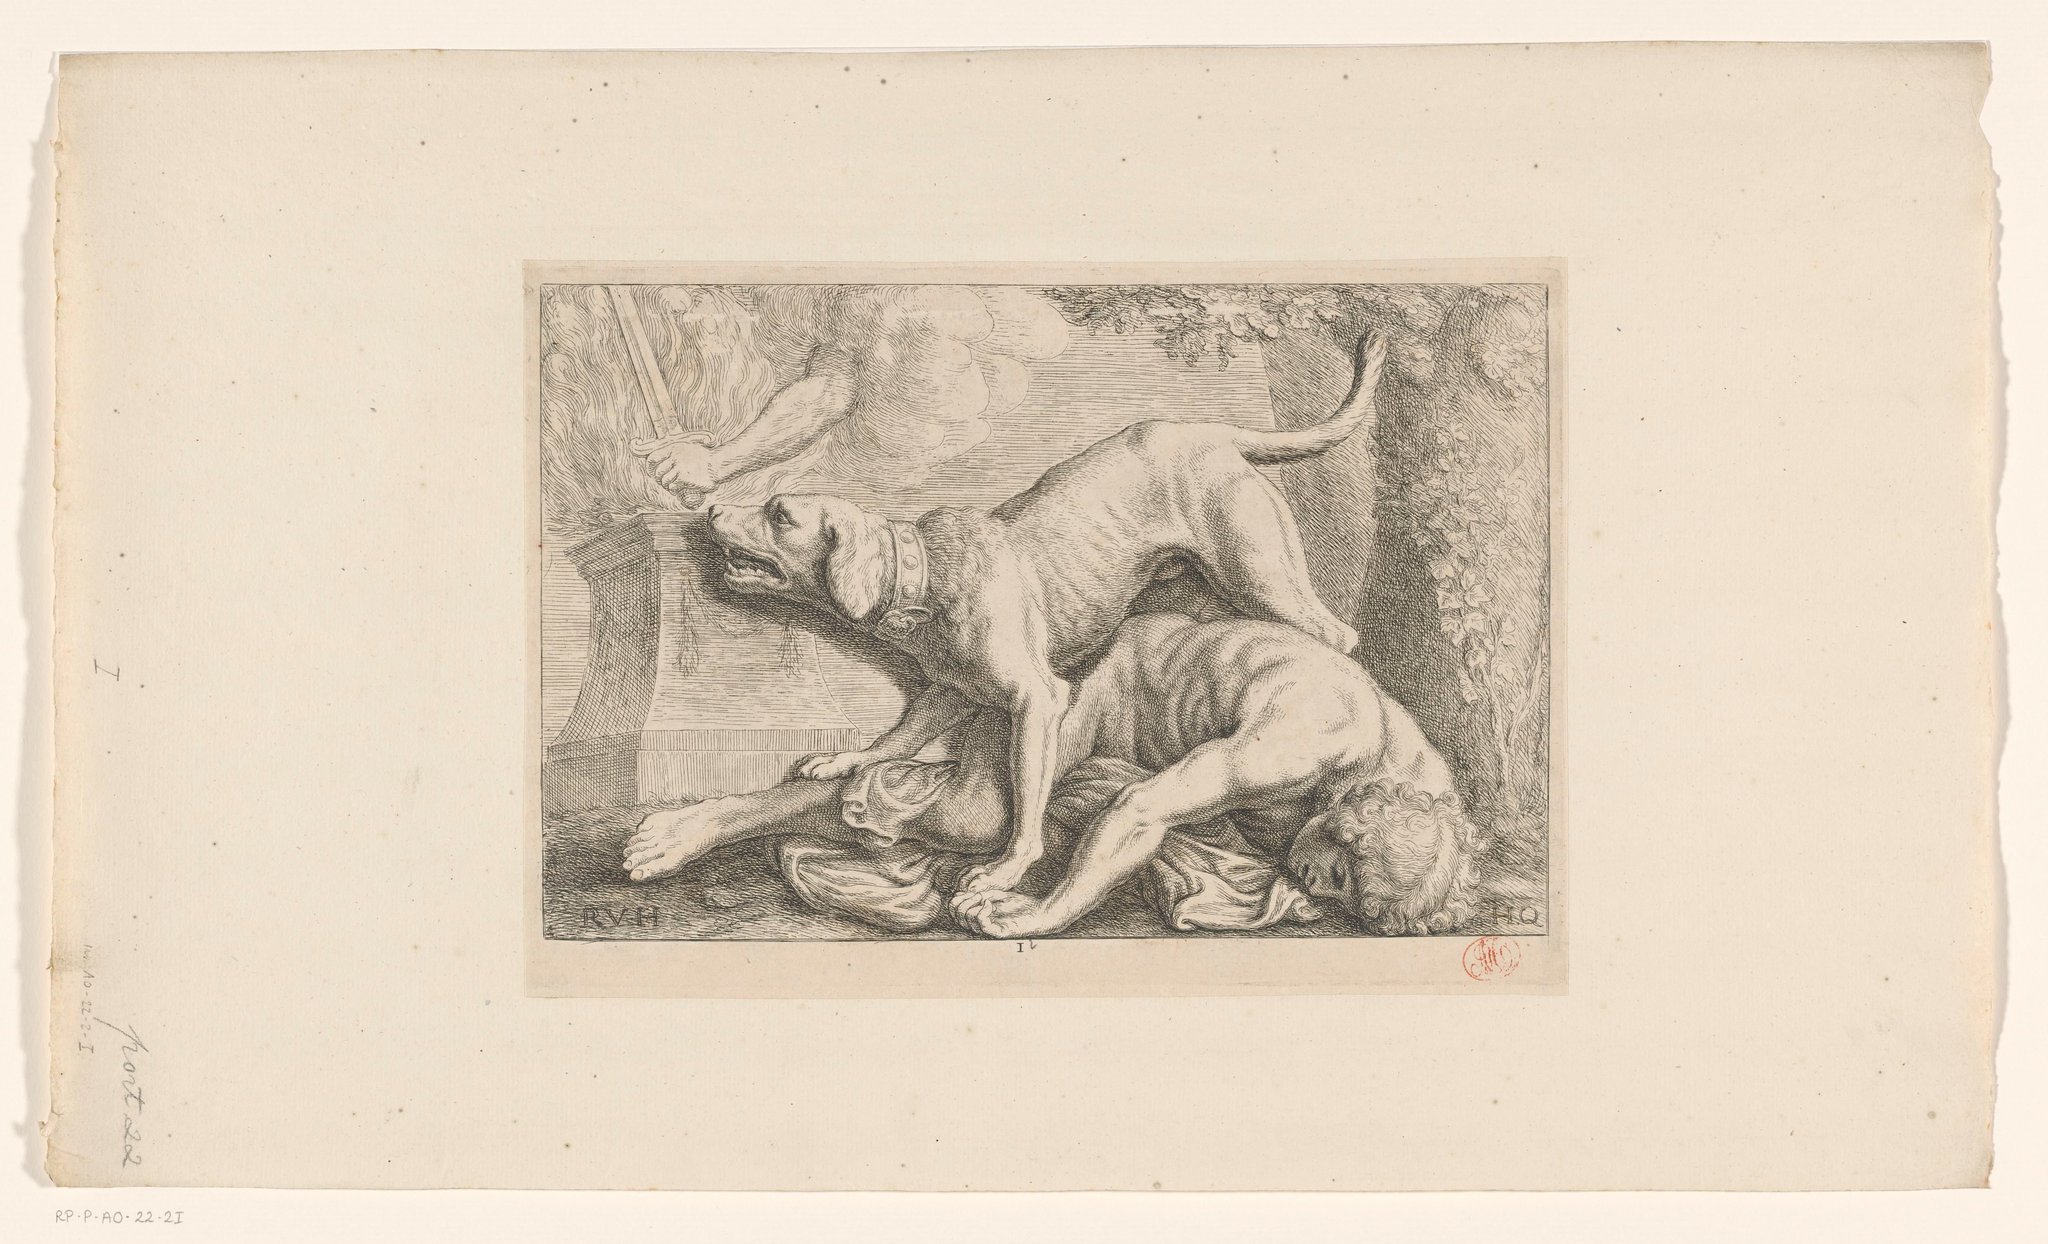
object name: book illustration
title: Reliëf met hond als allegorie op de Trouw boven de linker deur naar het Secretarie in het Stadhuis op de Dam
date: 1663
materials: paper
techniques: engraving, etching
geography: amsterdam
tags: faithfulness, 'bona fide', fidelity; 'fedeltà' (ripa), roman personifications of abstract concepts, frankness, loyalty; 'lealtà', 'realtà' (ripa), dog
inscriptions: collector's mark: Lugt 195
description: Prent gebruikt in: Secunca pars Praecipuarum effigierum ac ornamentorum amplissime Curiae Amstelrodamensis maiori ex parte in cadido marmore effectorum per Artum Quellinium eiusdem Civitatis Statuarium / Het tweede deel Van de voornaemste Statuen ende Cieraten van 't konst-rijcke Stadt-huys van Amstelredam 'tmeeste in Marmer gemaeckt door Artus Quellinus Beelthouwer der voorseyde Stadt. Amsterdam: Artus Quellinus (I), 1663. Zie RP-P-AO-22-2-1 voor bijhorende titelpagina. Zie RP-P-AO-22-2-2 voor bijhorend register. Zie RP-P-AO-22-2A, RP-P-AO-22-2B, RP-P-AO-22-2C-1, RP-P-AO-22-2C-2, RP-P-AO-22-2C-3, RP-P-AO-22-2C-4, RP-P-AO-22-2D-1, RP-P-AO-22-2D-2, RP-P-AO-22-2D-3, RP-P-AO-22-2E-1, RP-P-AO-22-2E-2, RP-P-AO-22-2E-3, RP-P-AO-22-2E-4, RP-P-AO-22-2F-1, RP-P-AO-22-2F-2, RP-P-AO-22-2F-3, RP-P-AO-22-2G, RP-P-AO-22-2H, RP-P-AO-22-2K, RP-P-AO-22-2L, RP-P-AO-22-2M, RP-P-AO-22-2N, RP-P-AO-22-2O-1, RP-P-AO-22-2O-2, RP-P-AO-22-2O-3, RP-P-AO-22-2O-4, RP-P-AO-22-2O-5, RP-P-AO-22-2O-6, RP-P-AO-22-2O-7, RP-P-AO-22-2P-1, RP-P-AO-22-2P-2, RP-P-AO-22-2Q-1, RP-P-AO-22-2Q-2, RP-P-AO-22-2Q-3, RP-P-AO-22-2R-1, RP-P-AO-22-2R-2, RP-P-AO-22-2R-3, RP-P-AO-22-2S, RP-P-AO-22-2T-1, RP-P-AO-22-2T-2, RP-P-AO-22-2T-3, RP-P-AO-22-2T-4, RP-P-AO-22-2V-1, RP-P-AO-22-2V-2, RP-P-AO-22-2W-1, RP-P-AO-22-2W-2, RP-P-AO-22-2X-1, RP-P-AO-22-2X-2 en RP-P-AO-22-2X-3 voor andere prenten uit deze publicatie. Zelfde staat van prent ook gebruikt in: Secunca pars Praecipuarum effigierum ac ornamentorum amplissime Curiae Amstelrodamensis maiori ex parte in cadido marmore effectorum per Artum Quellinium eiusdem Civitatis Statuarium / Het tweede deel Van de voornaemste Statuen ende Cieraten van 't konst-rijcke Stadt-huys van Amstelredam 'tmeeste in Marmer gemaeckt door Artus Quellinus Beelthouwer der voorseyde Stadt. Amsterdam: Frederik de Wit, 1668. Latere staat van prent ook gebruikt in: Architecture peinture et sculpture de la Maison de Ville d'Amsterdam, representee en CIX. figures en taille-douce (…). Amsterdam: David Mortier, 1719. En in: Architecture peinture et sculpture de la Maison de Ville d'Amsterdam, representee en CIX. figures en taille-douce (…). Amsterdam: Gerard Valck, 1719. En in: Bouw schilder en beeldhouwkonst, van het Stadhuis te Amsteldam, vertoont in CIX figuuren (…). Amsterdam: Covens & Mortier & Covens Jr., s.a. (1774-1783).